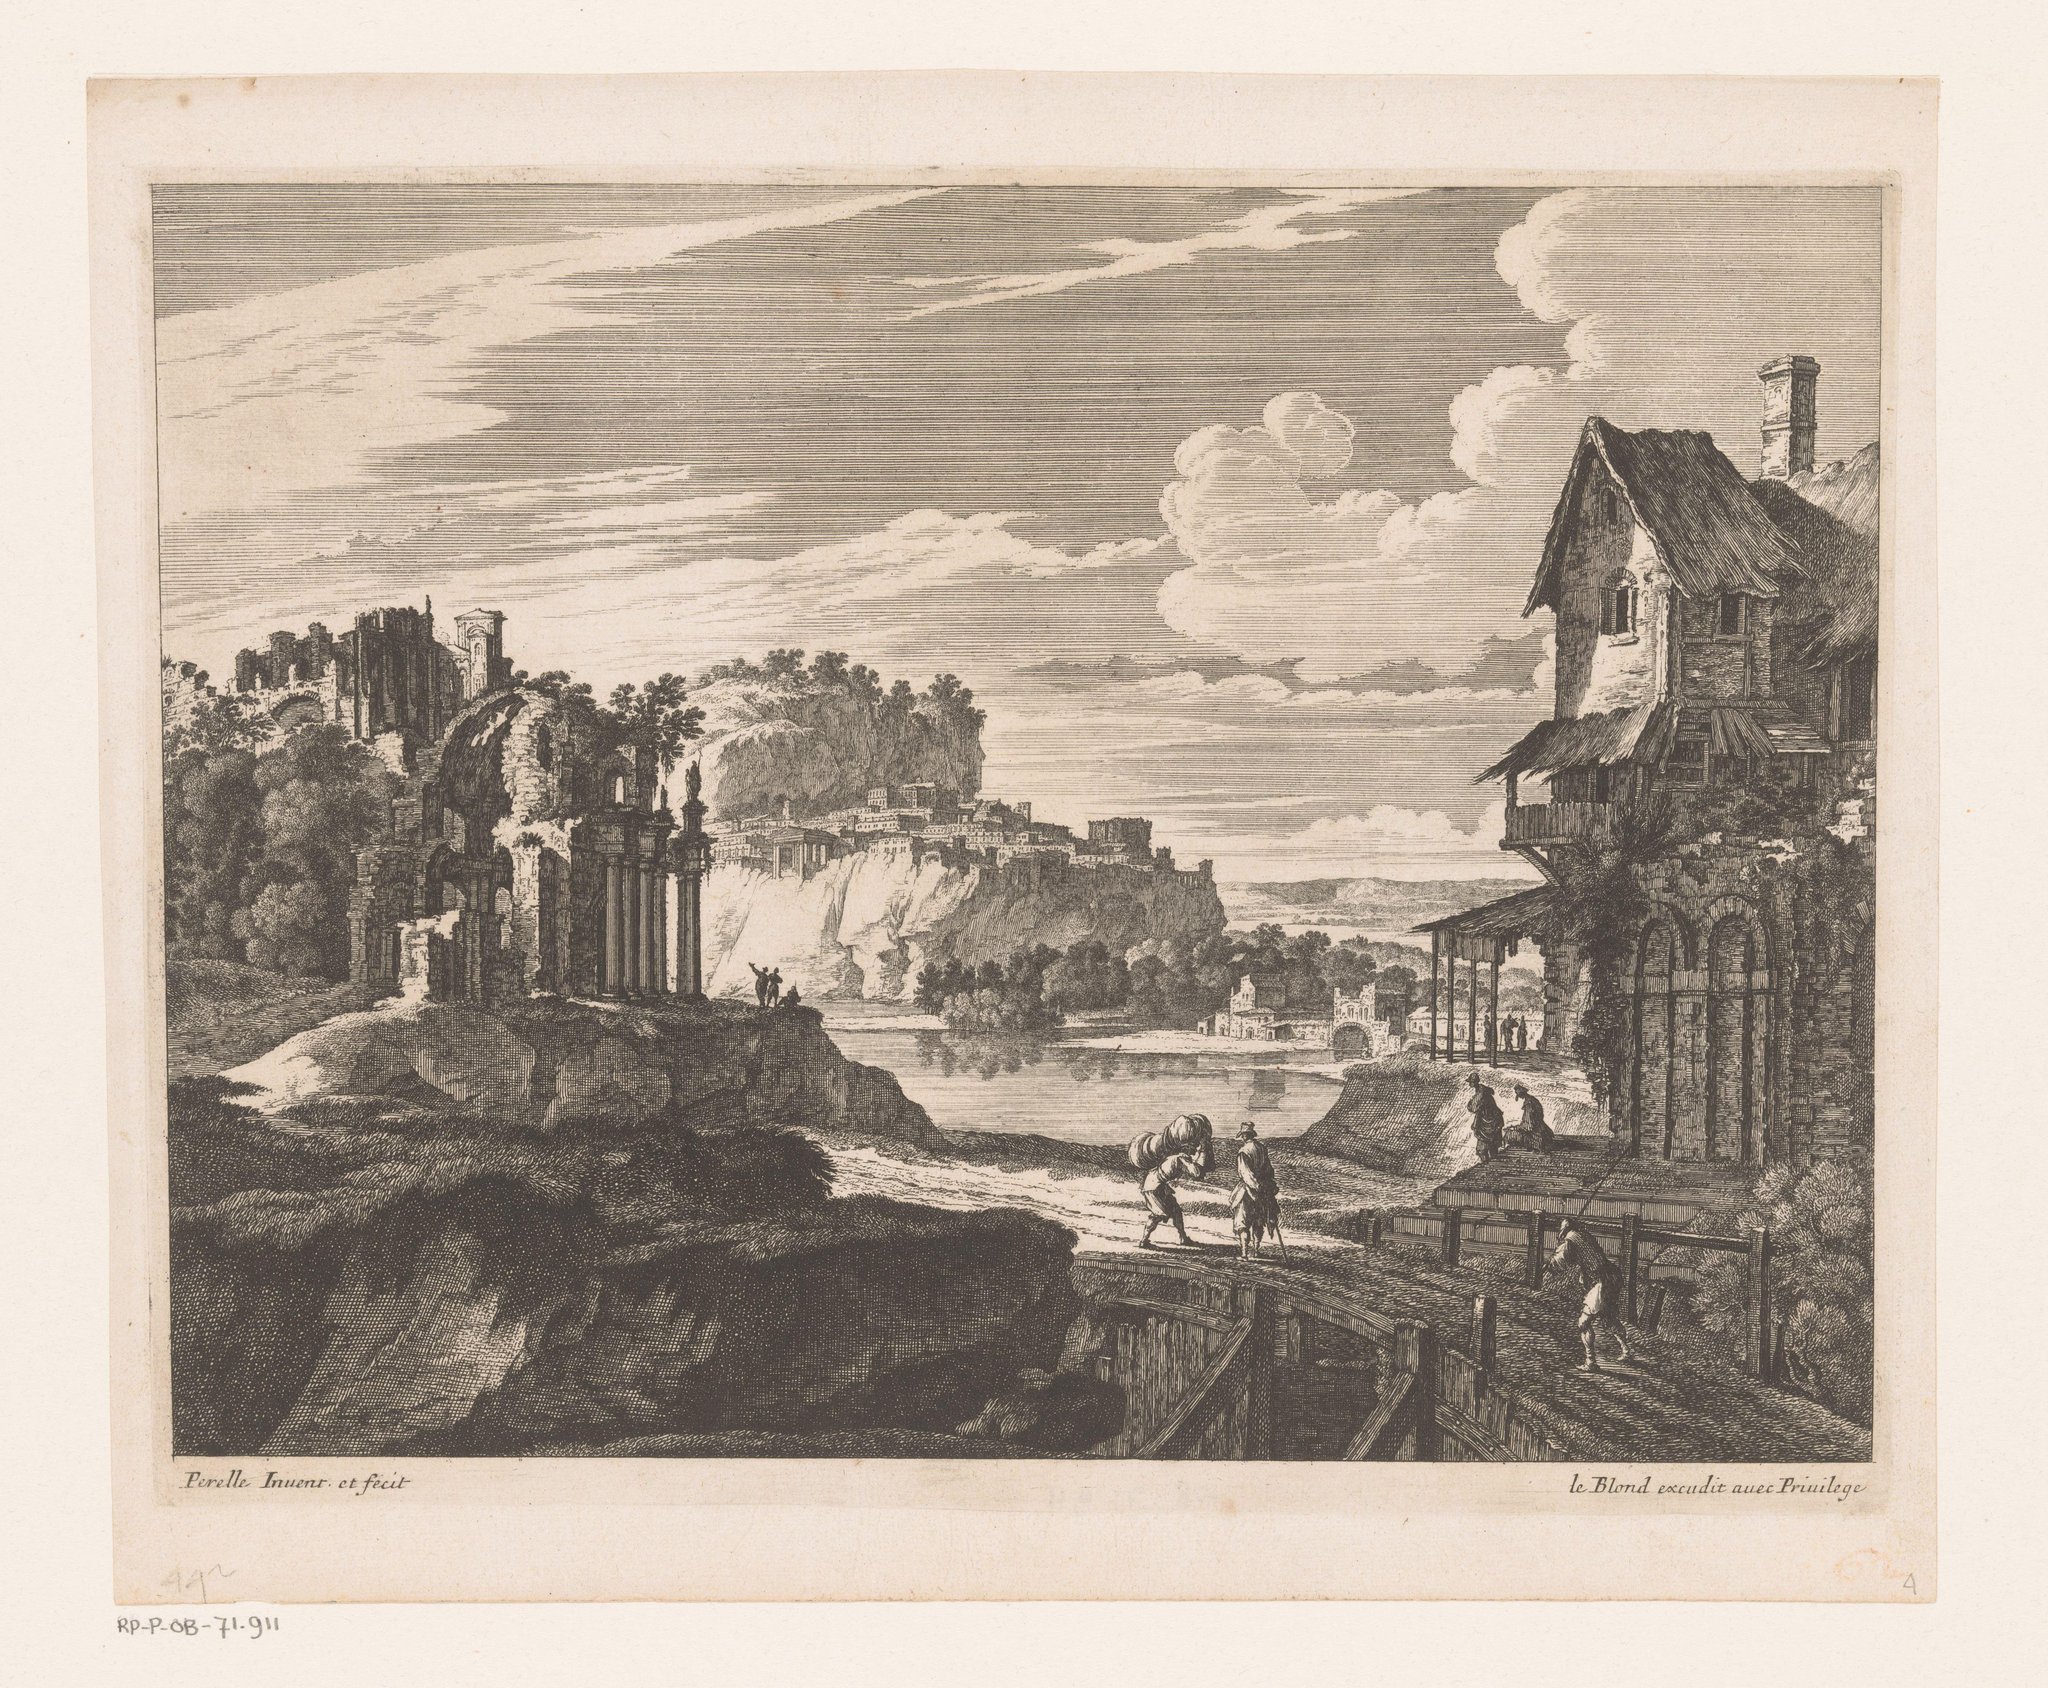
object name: print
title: Landschap met huizen en ruïnes langs rivier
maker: jean leblond (i)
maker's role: publisher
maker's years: 1590-1666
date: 1613-1666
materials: paper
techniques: engraving, etching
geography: france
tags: landscapes, landscape with ruins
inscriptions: collector's mark: Lugt 240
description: Prenten met het signatuur 'Perelle' kunnen zowel door vader Gabriel als door zonen Nicolas en Adam gemaakt zijn.